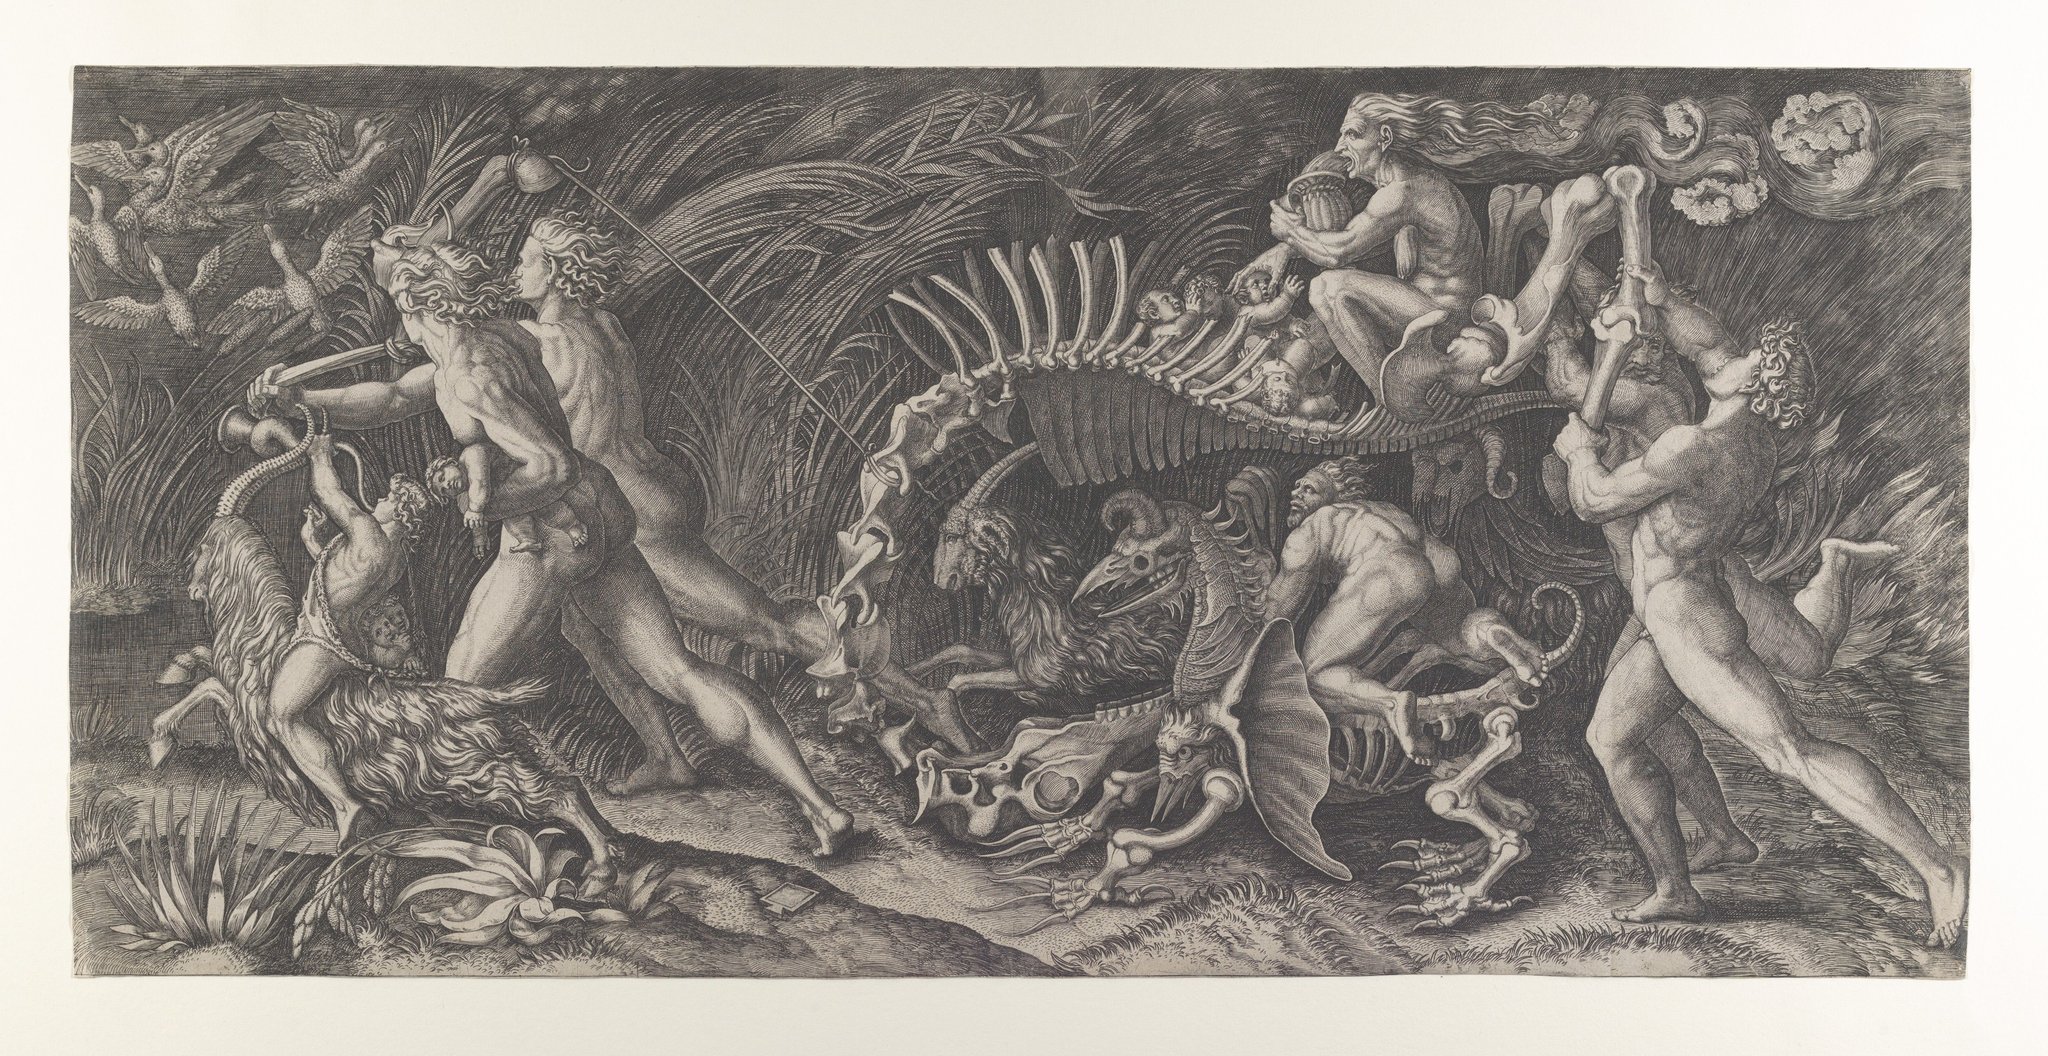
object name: print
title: Lo Stregozzo: a female witch riding on an animal skeleton, preceded by two men and a boy on a goat blowing on a horn, another naked man behind carrying two bones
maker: agostino veneziano (agostino dei musi)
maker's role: artist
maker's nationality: italian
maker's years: 1490-1536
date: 1515-1525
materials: horn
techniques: engraving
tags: skeletons,boys,male nudes,female nudes,goats,witches